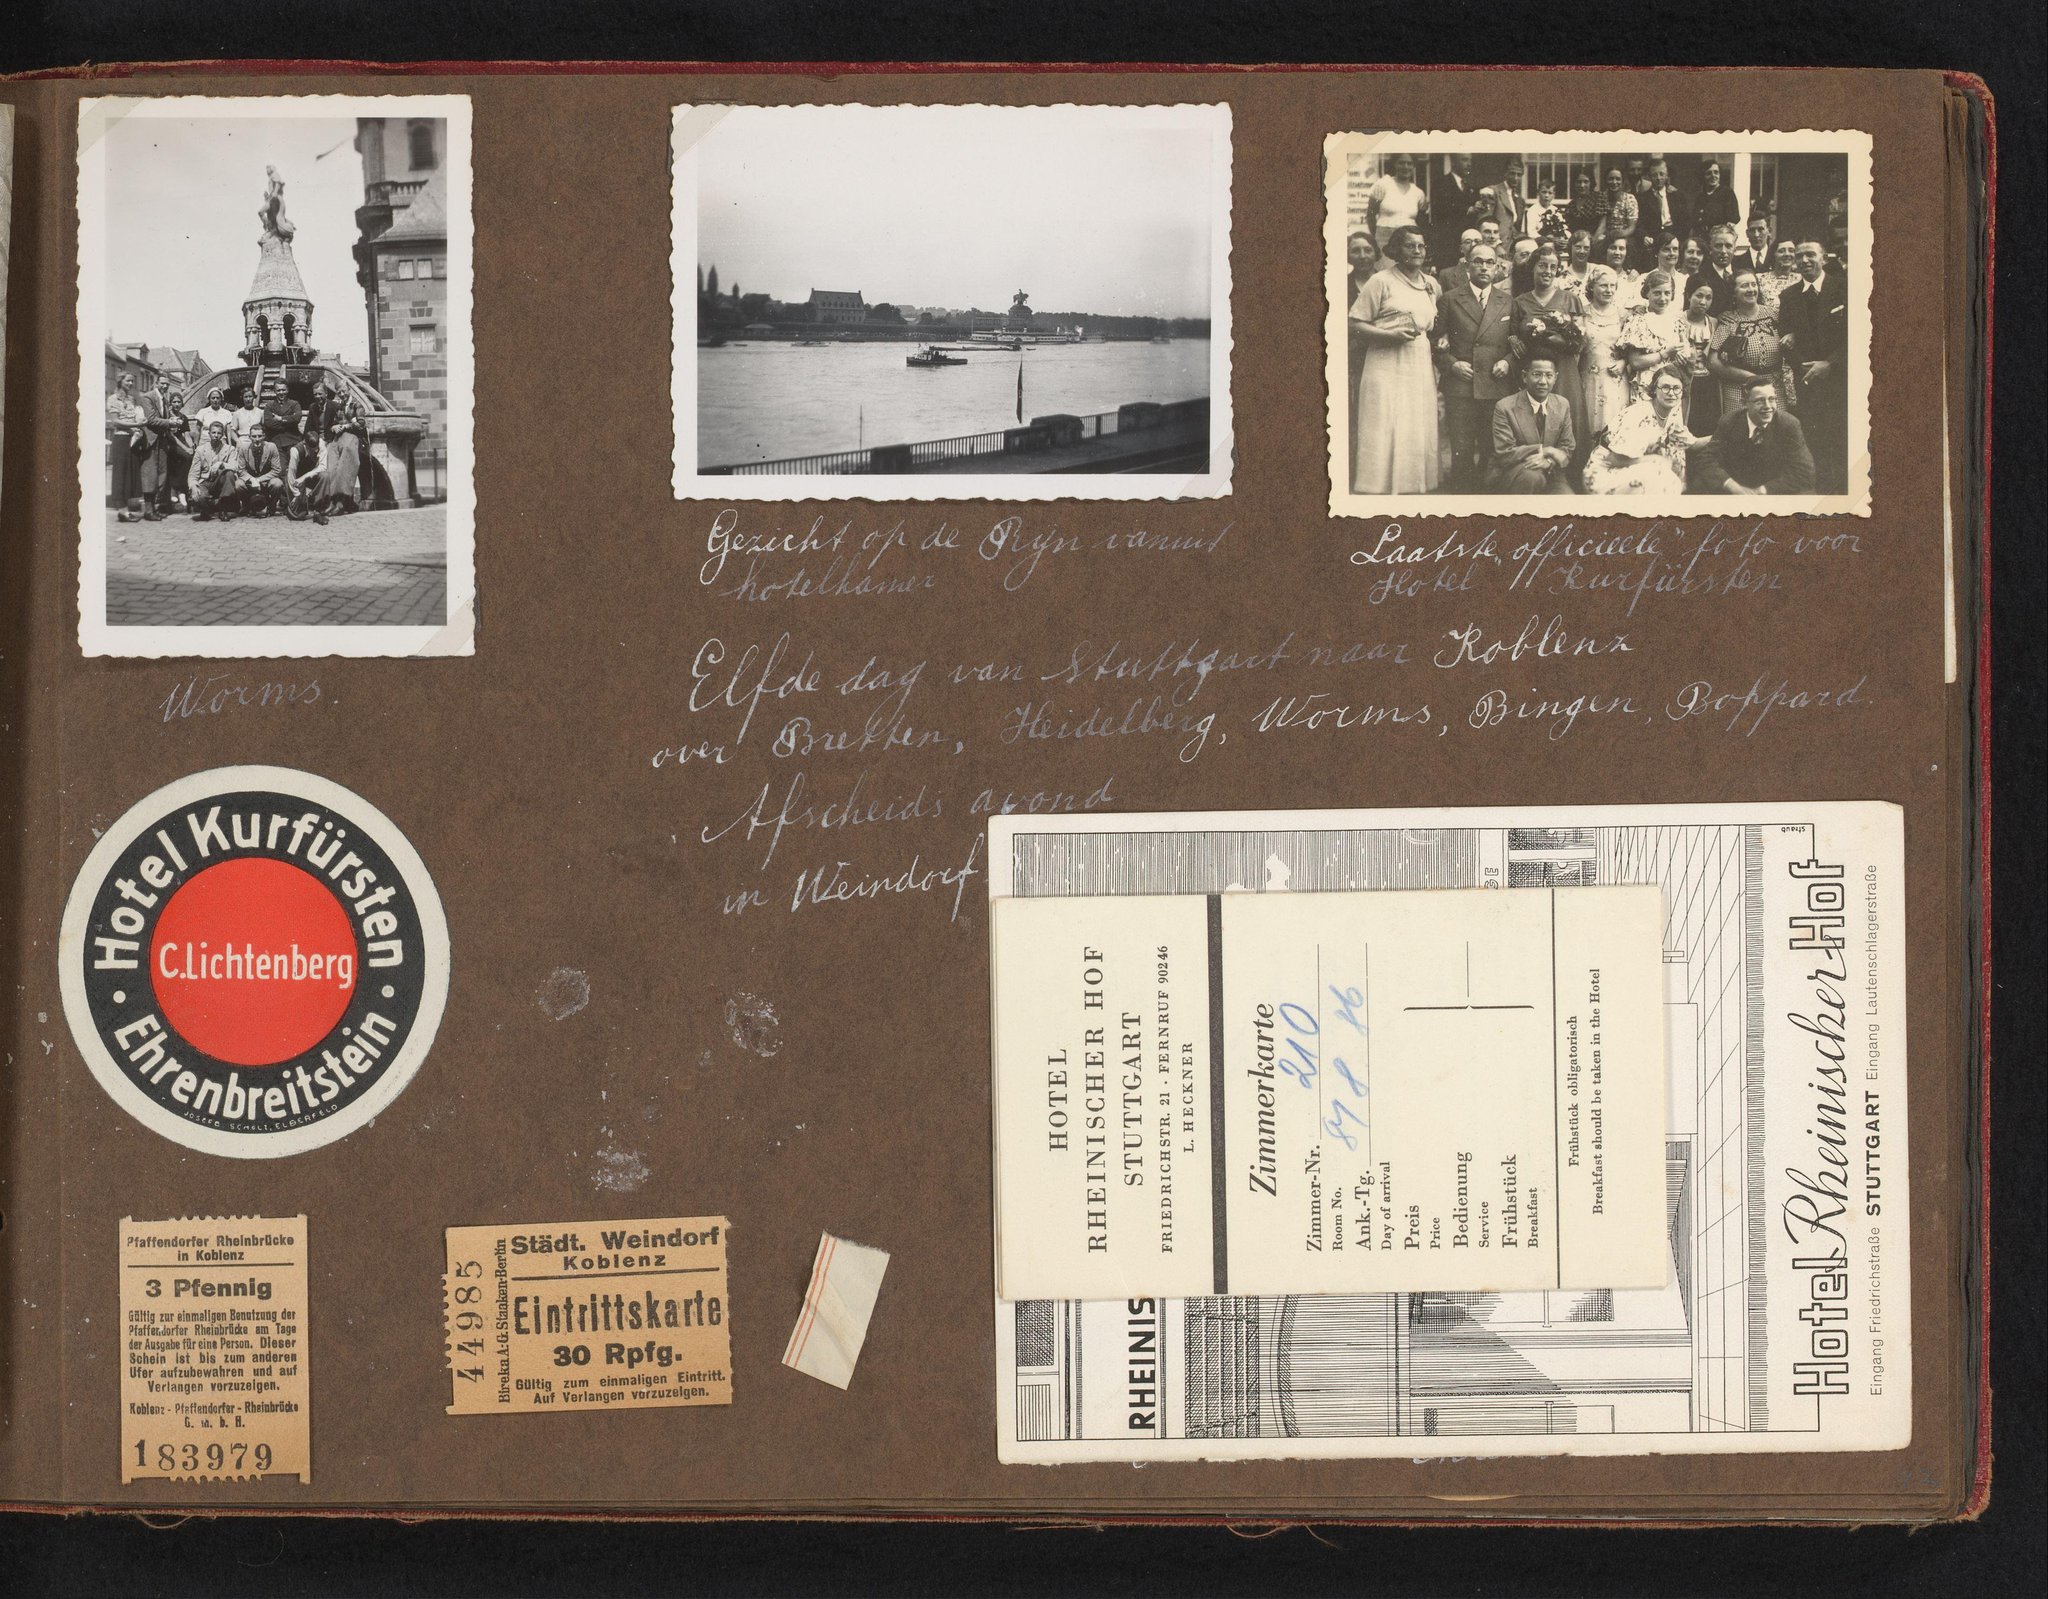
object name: photograph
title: Elfde dag van Stuttgart naar Koblenz ...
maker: Anonymous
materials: paper, photographic support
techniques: gelatin silver print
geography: germany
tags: outing, pleasure trip, hotel, hostelry, inn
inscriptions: inscription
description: Albumblad met drie foto's te Worms en Stuttgart en een laatste groepsfoto van het reisgezelschap. Met enkele toegangskaartjes en folder van het hotel in Stuttgart. Verslag van een twaalfdaagse groepsreis per autobus naar Salzburgerland en Beieren van 30 juli tot 10 augustus 1936. Onderdeel van het reisalbum van de familie Van den Broek 1935-1937.